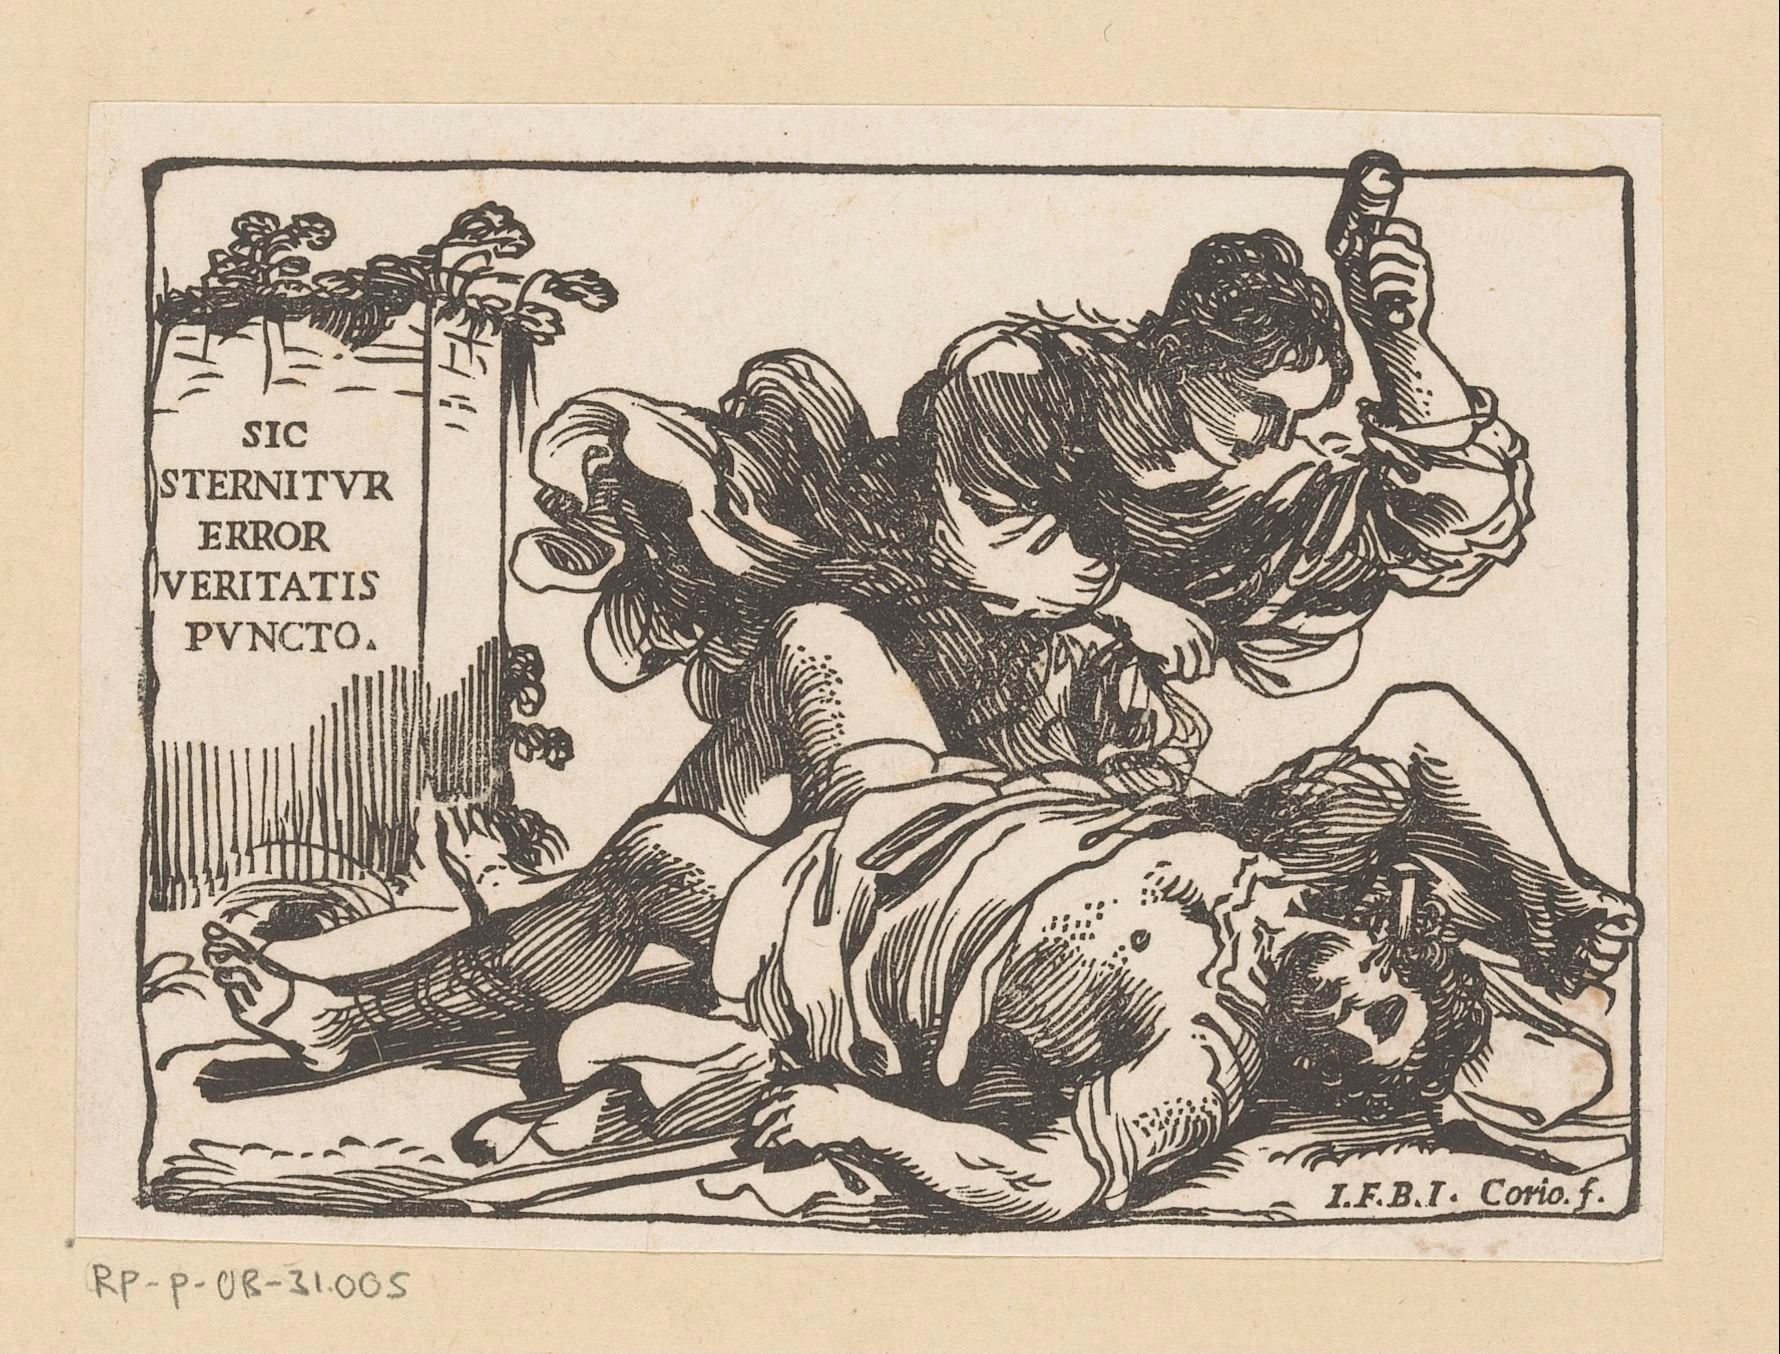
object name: print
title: Jaël doodt Sisera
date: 1599-1649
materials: paper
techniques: woodcut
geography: italy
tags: jael kills the sleeping sisera by hitting the nail through his temples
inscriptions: collector's mark: Lugt 240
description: Jaël vermoordt de slapende Sisera die toevlucht heeft gezocht in haar tent. Met een hamer slaat ze een pin door zijn hoofd.